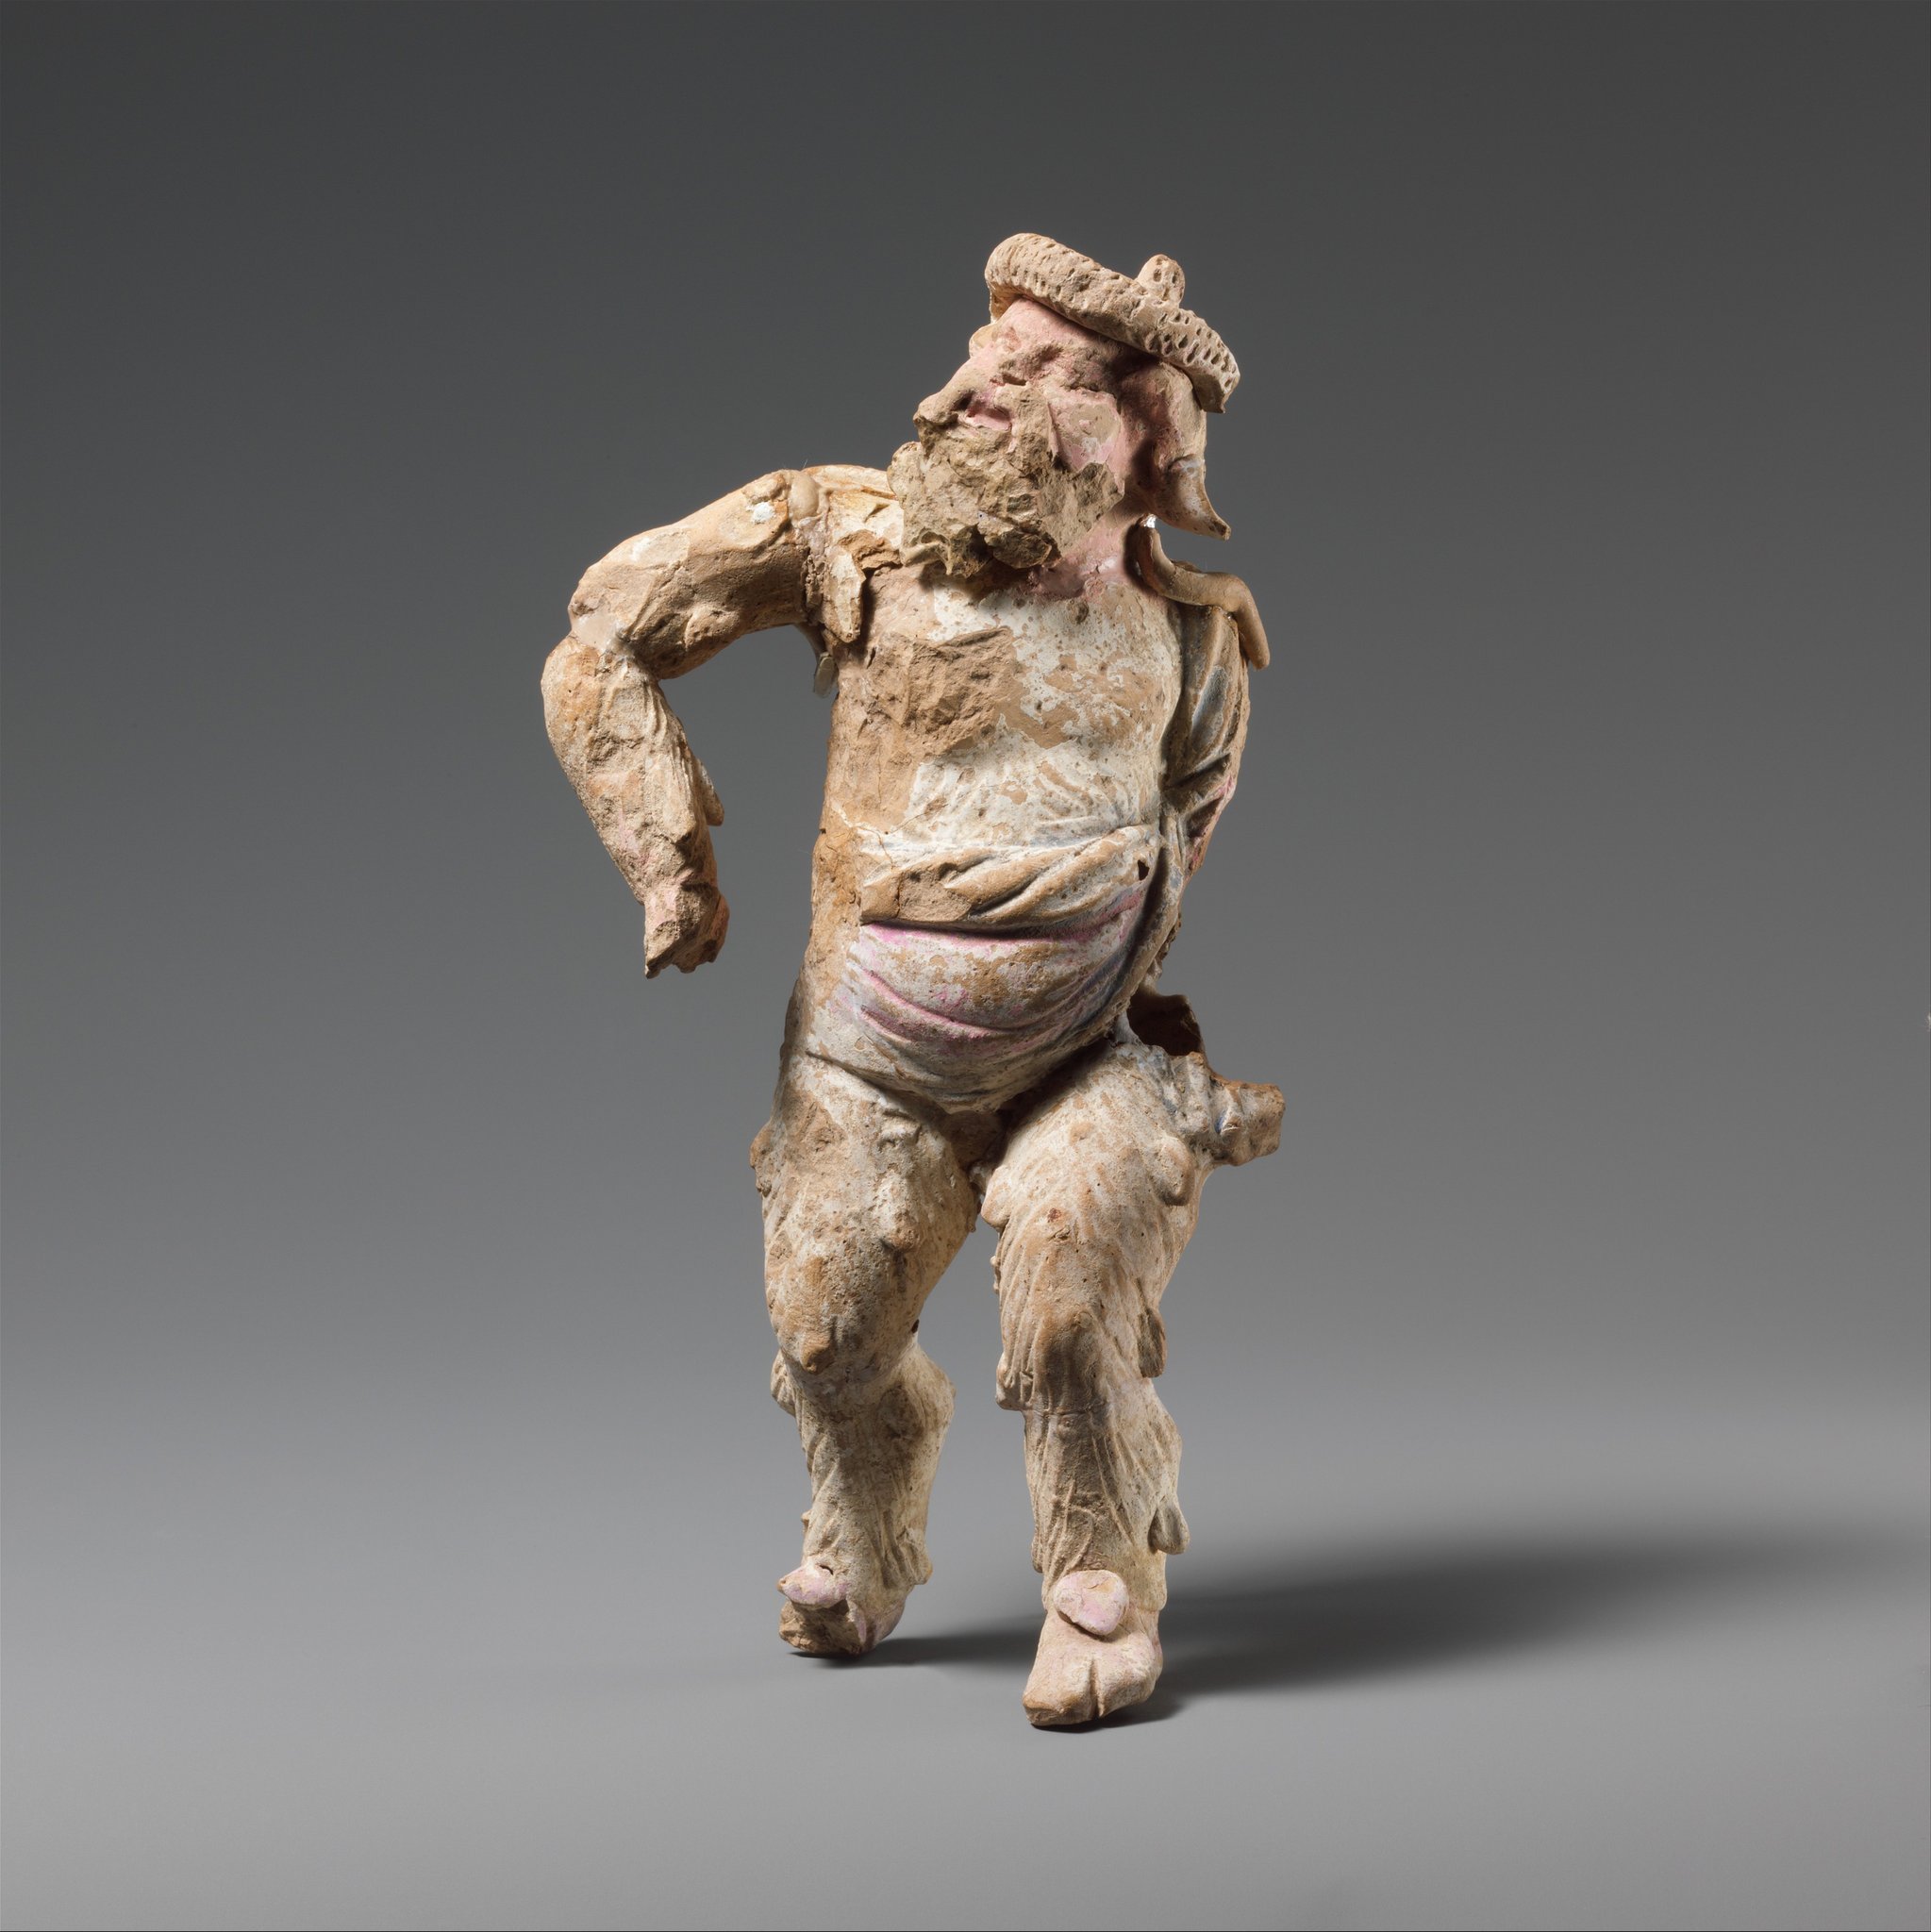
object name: statuette of a satyr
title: Terracotta statuette of a satyr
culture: greek, south italian, tarentine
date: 334-268 BCE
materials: terracotta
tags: satyrs